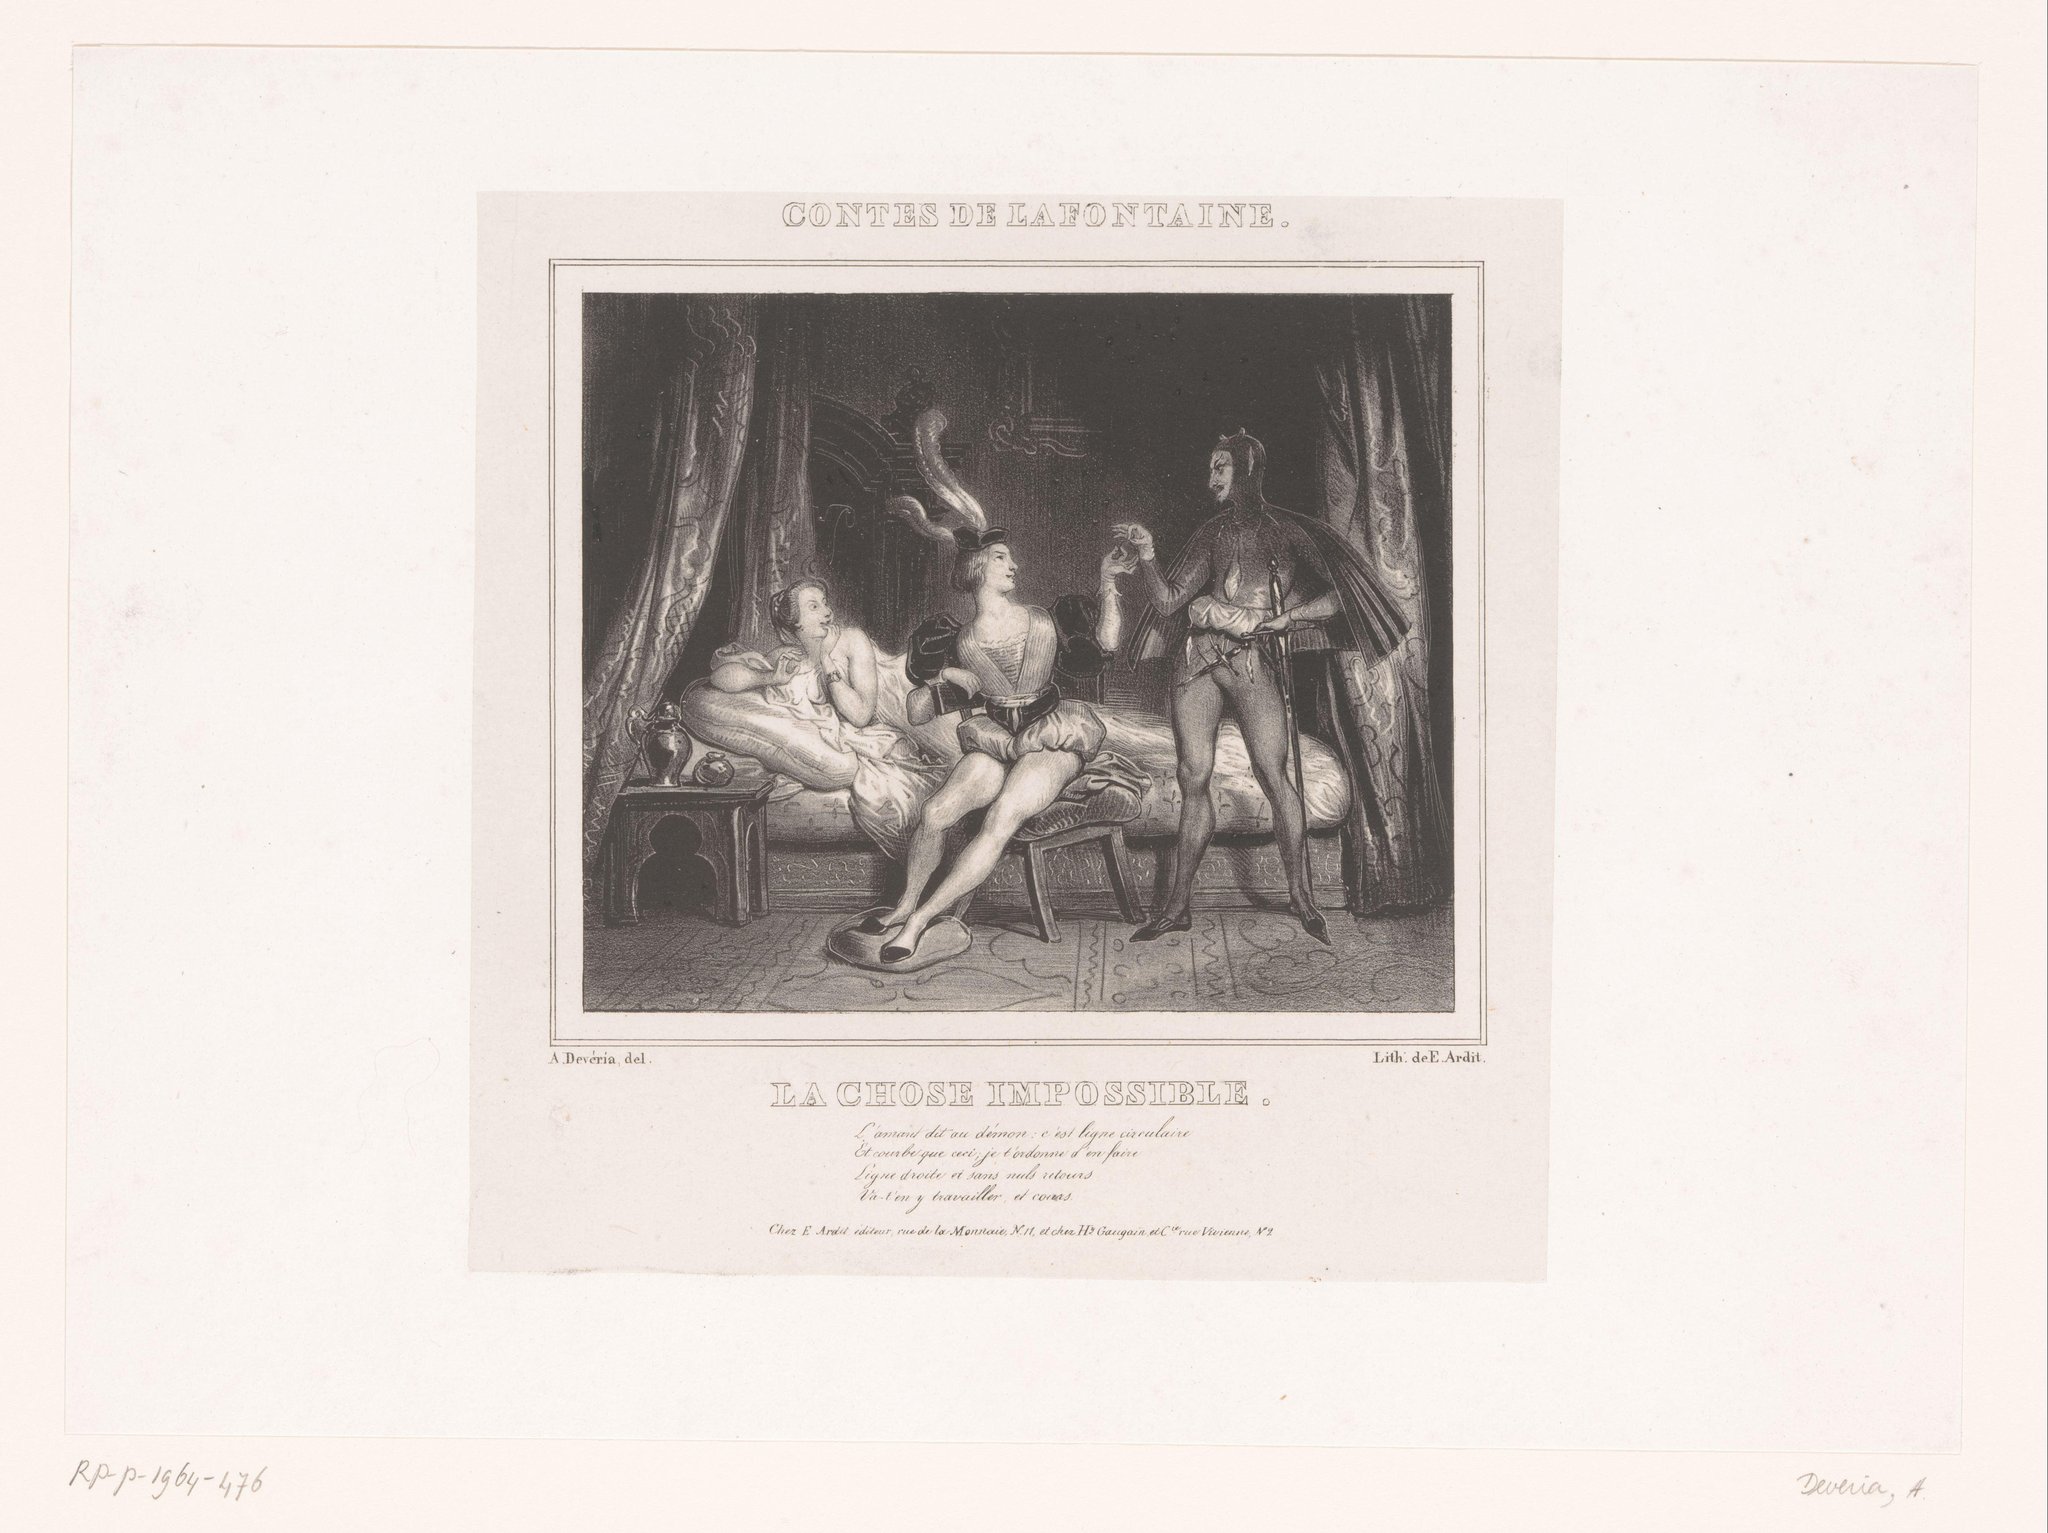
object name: print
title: Verhalen van Jean de La Fontaine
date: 1823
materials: paper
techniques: lithograph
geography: paris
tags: pact with the devil, selling one's soul to the devil, lovers brought together by a third person, bedroom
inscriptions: collector's mark: Lugt 2228a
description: De scène komt uit 'La chose impossible', een gedicht van Jean de La Fontaine.